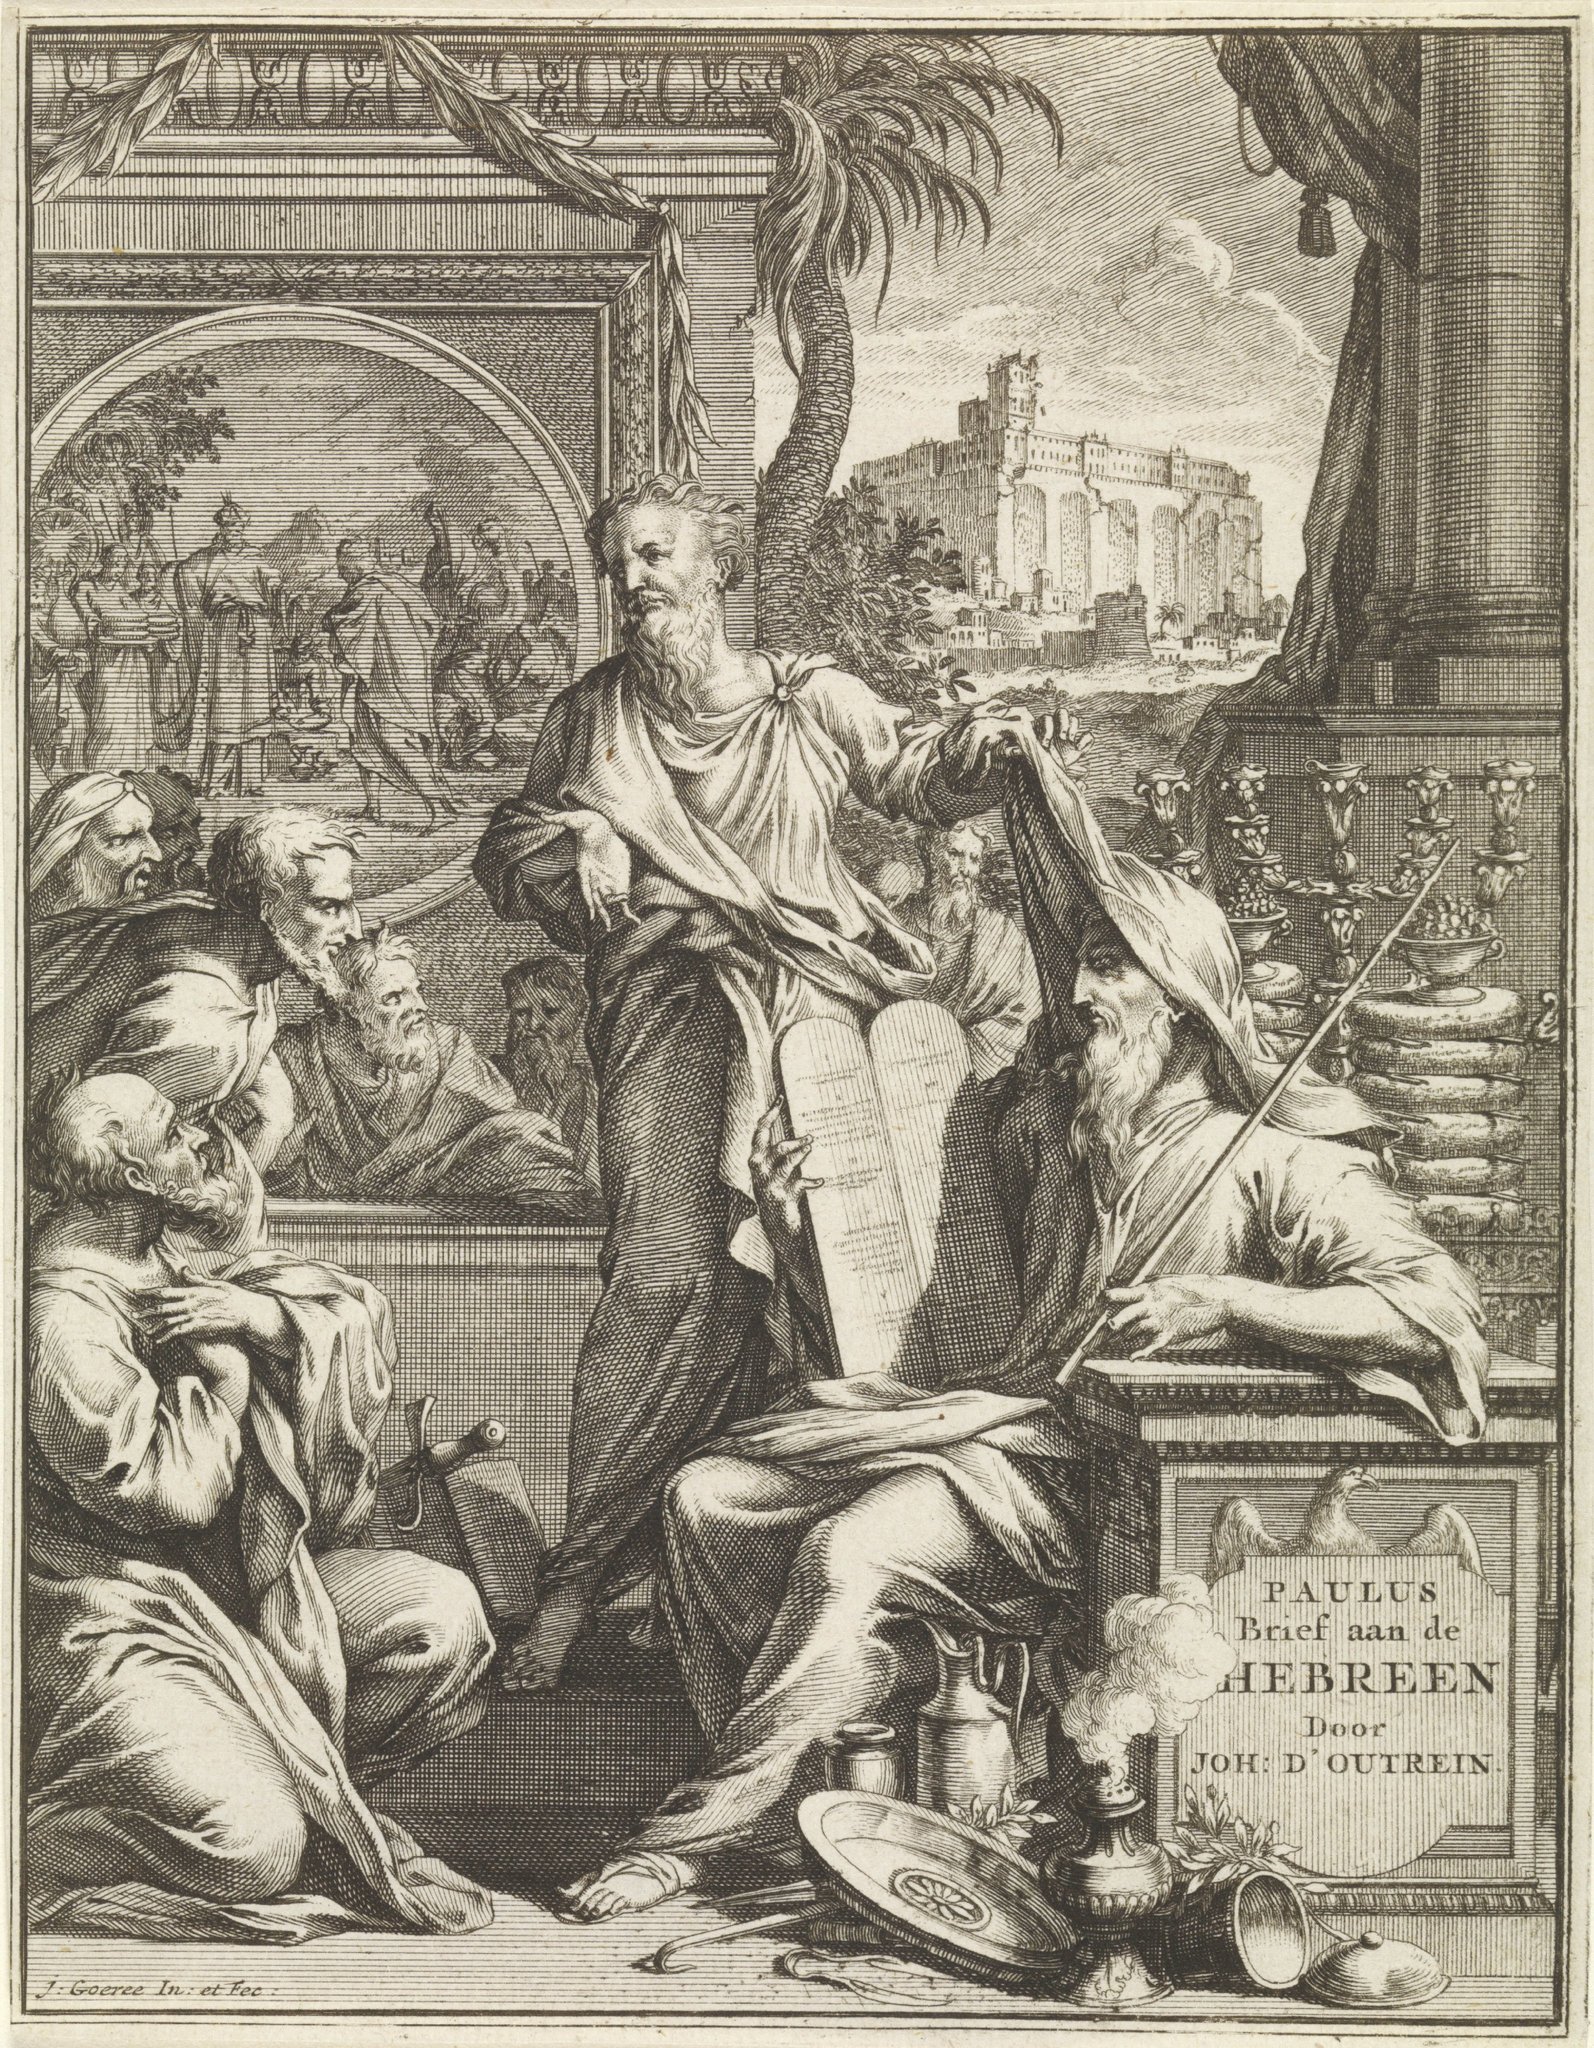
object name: titelblad, titelpagina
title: Titelpagina voor Johannes d'Outrein, De sendbrief van Paulus aan de Hebreen, 1711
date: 1711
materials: paper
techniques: engraving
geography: amsterdam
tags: landscape with ruins, moses (not in biblical context); possible attributes: rays of light or horns on his head, rod, tables of the law, epistle (of paul) to the hebrews, the apostle paul of tarsus; possible attributes: book, scroll, sword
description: De apostel Paulus onthult aan enkele toeschouwers de zittende figuur van Mozes. Mozes heeft de tien geboden vast en leunt tegen een steen met de titel van het boekwerk. Op de achtergrond een ruïne.